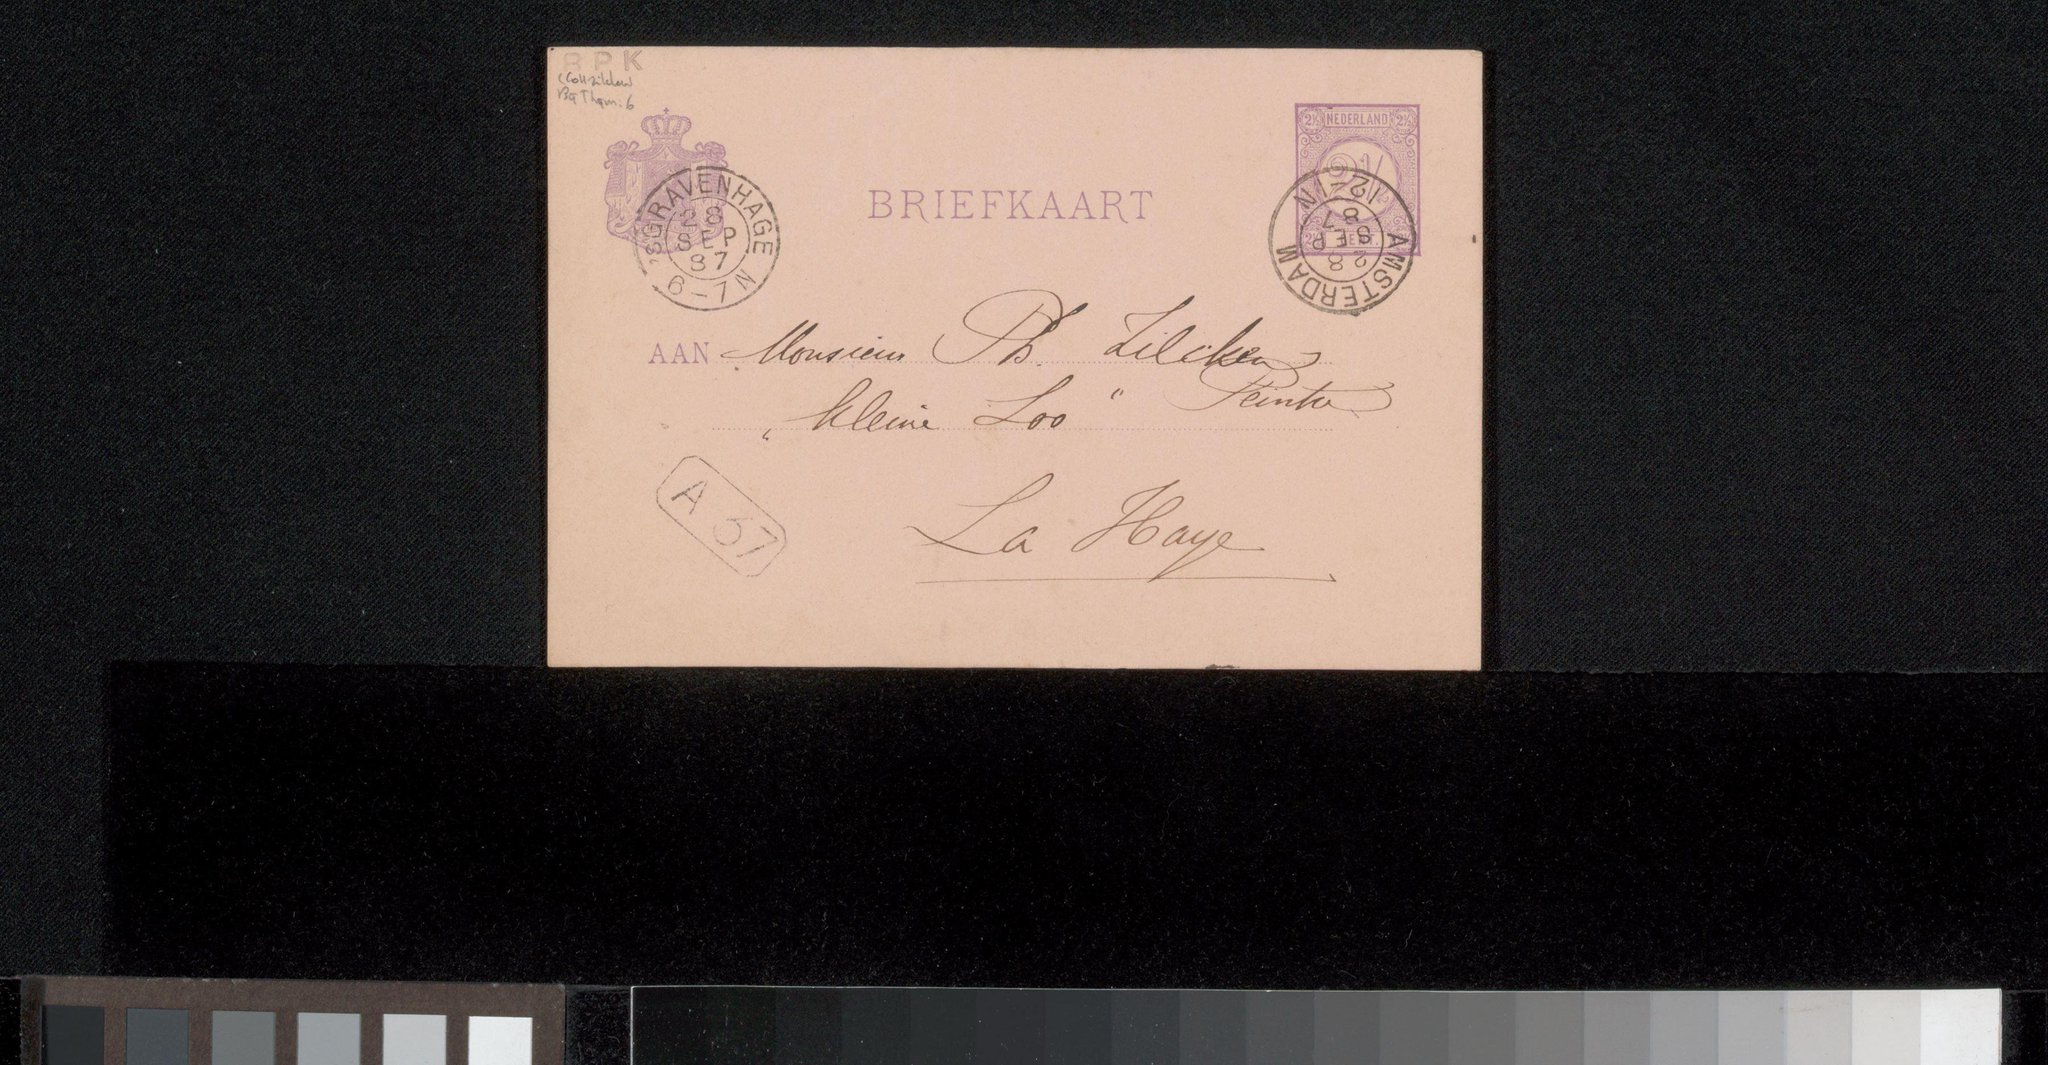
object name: postcard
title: Briefkaart aan Philip Zilcken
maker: catharina alberdingk thijm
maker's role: schrijver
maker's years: 1848-1908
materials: cardboard, ink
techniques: pen, writing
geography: amsterdam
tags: maria zubli-van den berch van heemstede, the hague, painter, philip zilcken, exhibition ~ art, amsterdam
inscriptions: collector's mark: ‘RPK’